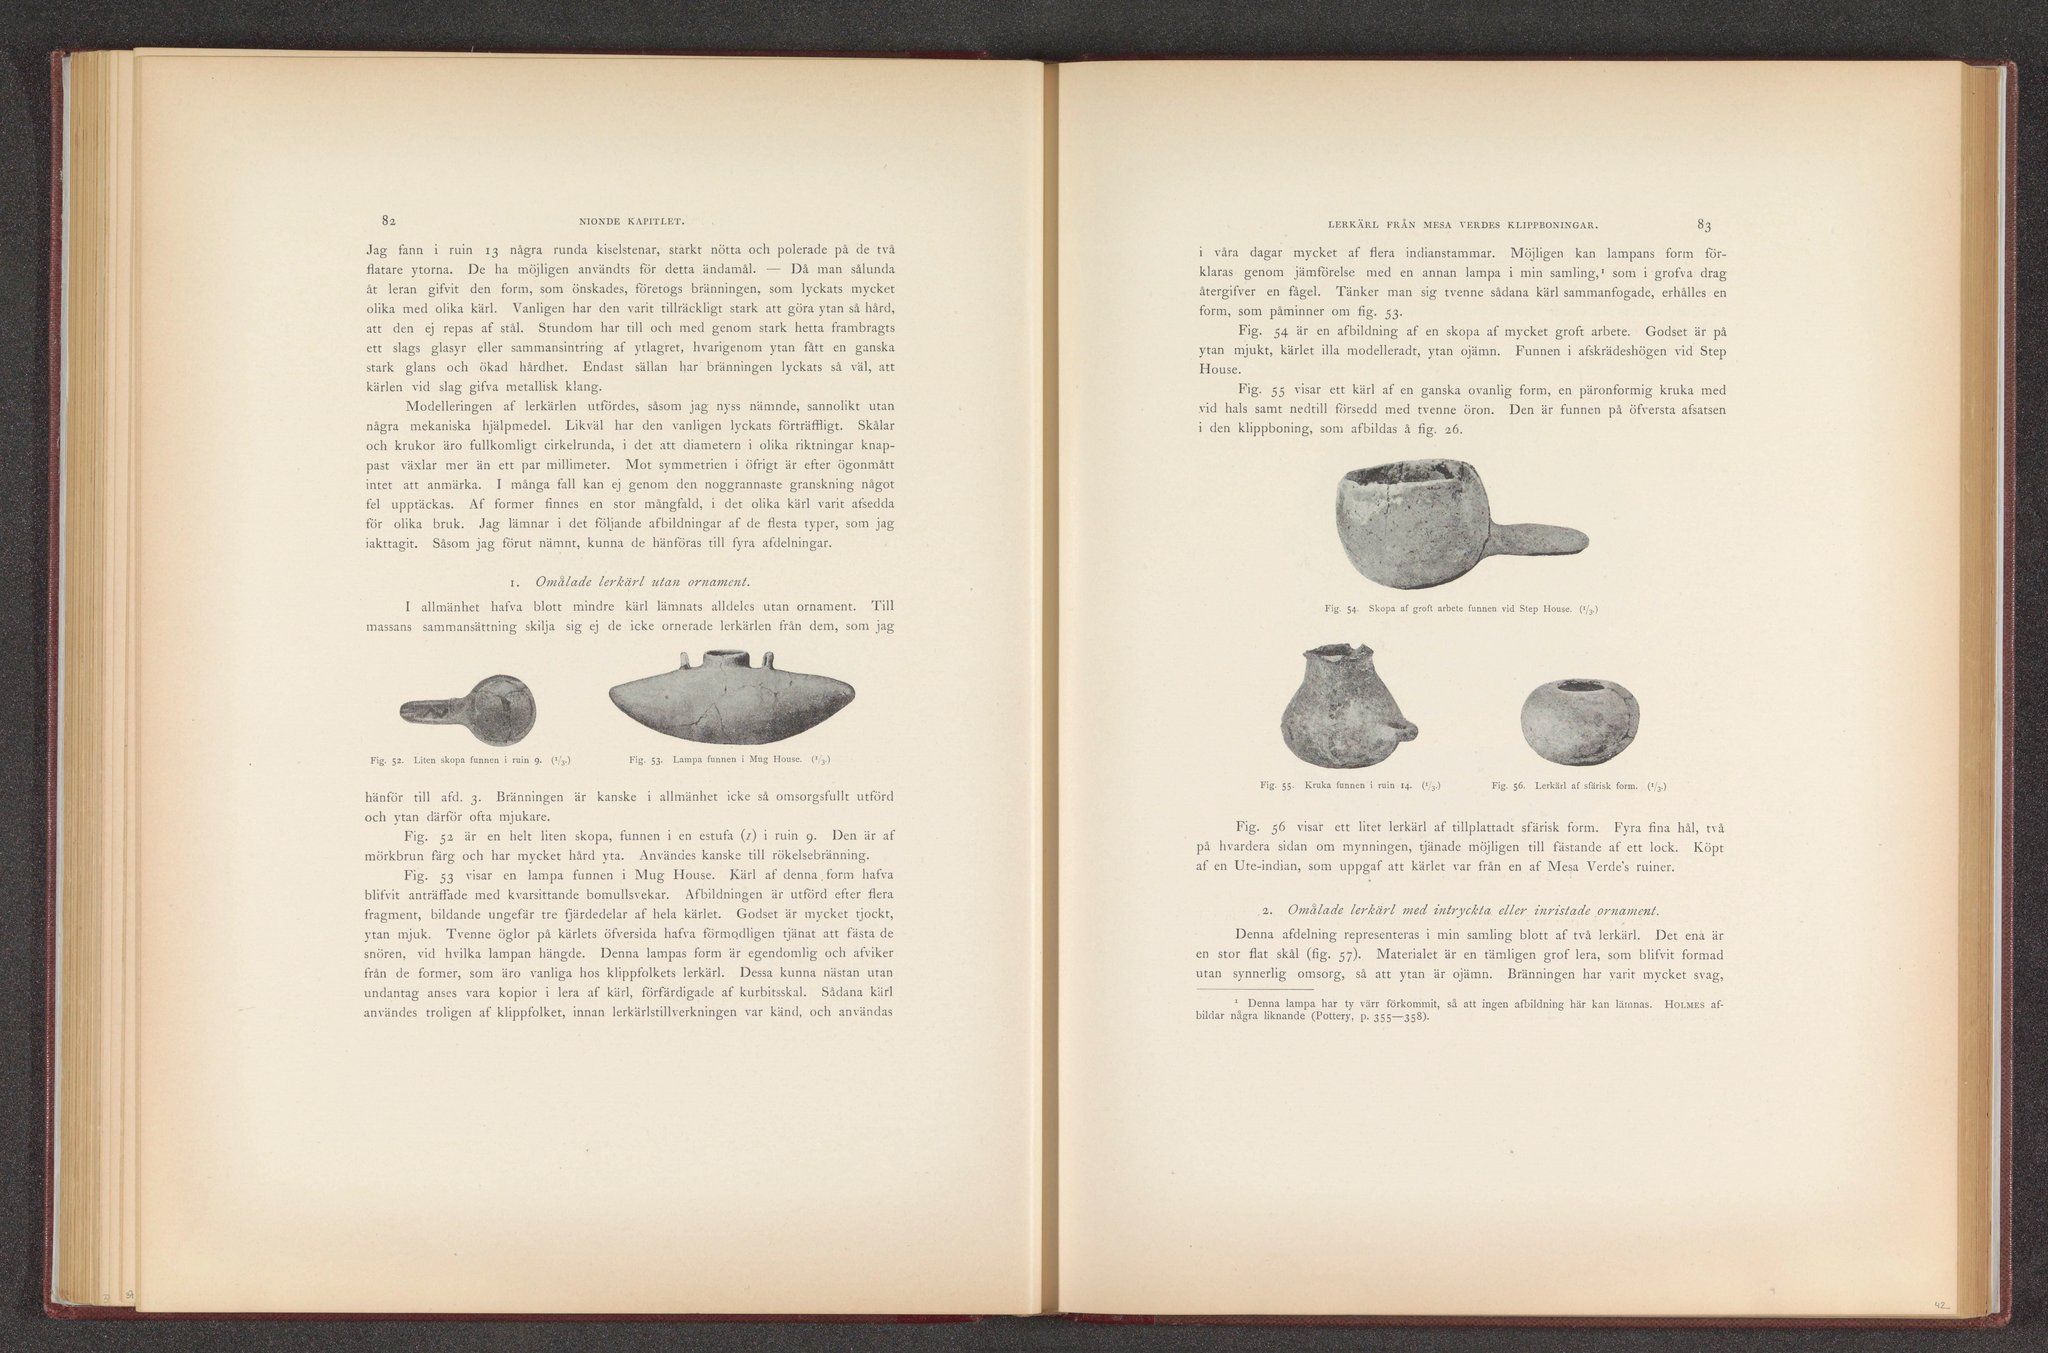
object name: page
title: Skopa af groft arbete funnen vid Step House. Kruka funnen i ruin 14. Lerkärl af sfärisk form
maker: gustaf nordenskiöld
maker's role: fotograaf, schrijver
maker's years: 1868-1895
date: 1891-1893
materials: paper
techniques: autotype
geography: mesa verde national park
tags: container of ceramics: jar, jug, pot, vase, dish, plate, saucer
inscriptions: number: ‘Fig. 54. Fig 55. Fig. 56.’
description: Boven: kom, onder: kruik en een bolvormig voorwerp.